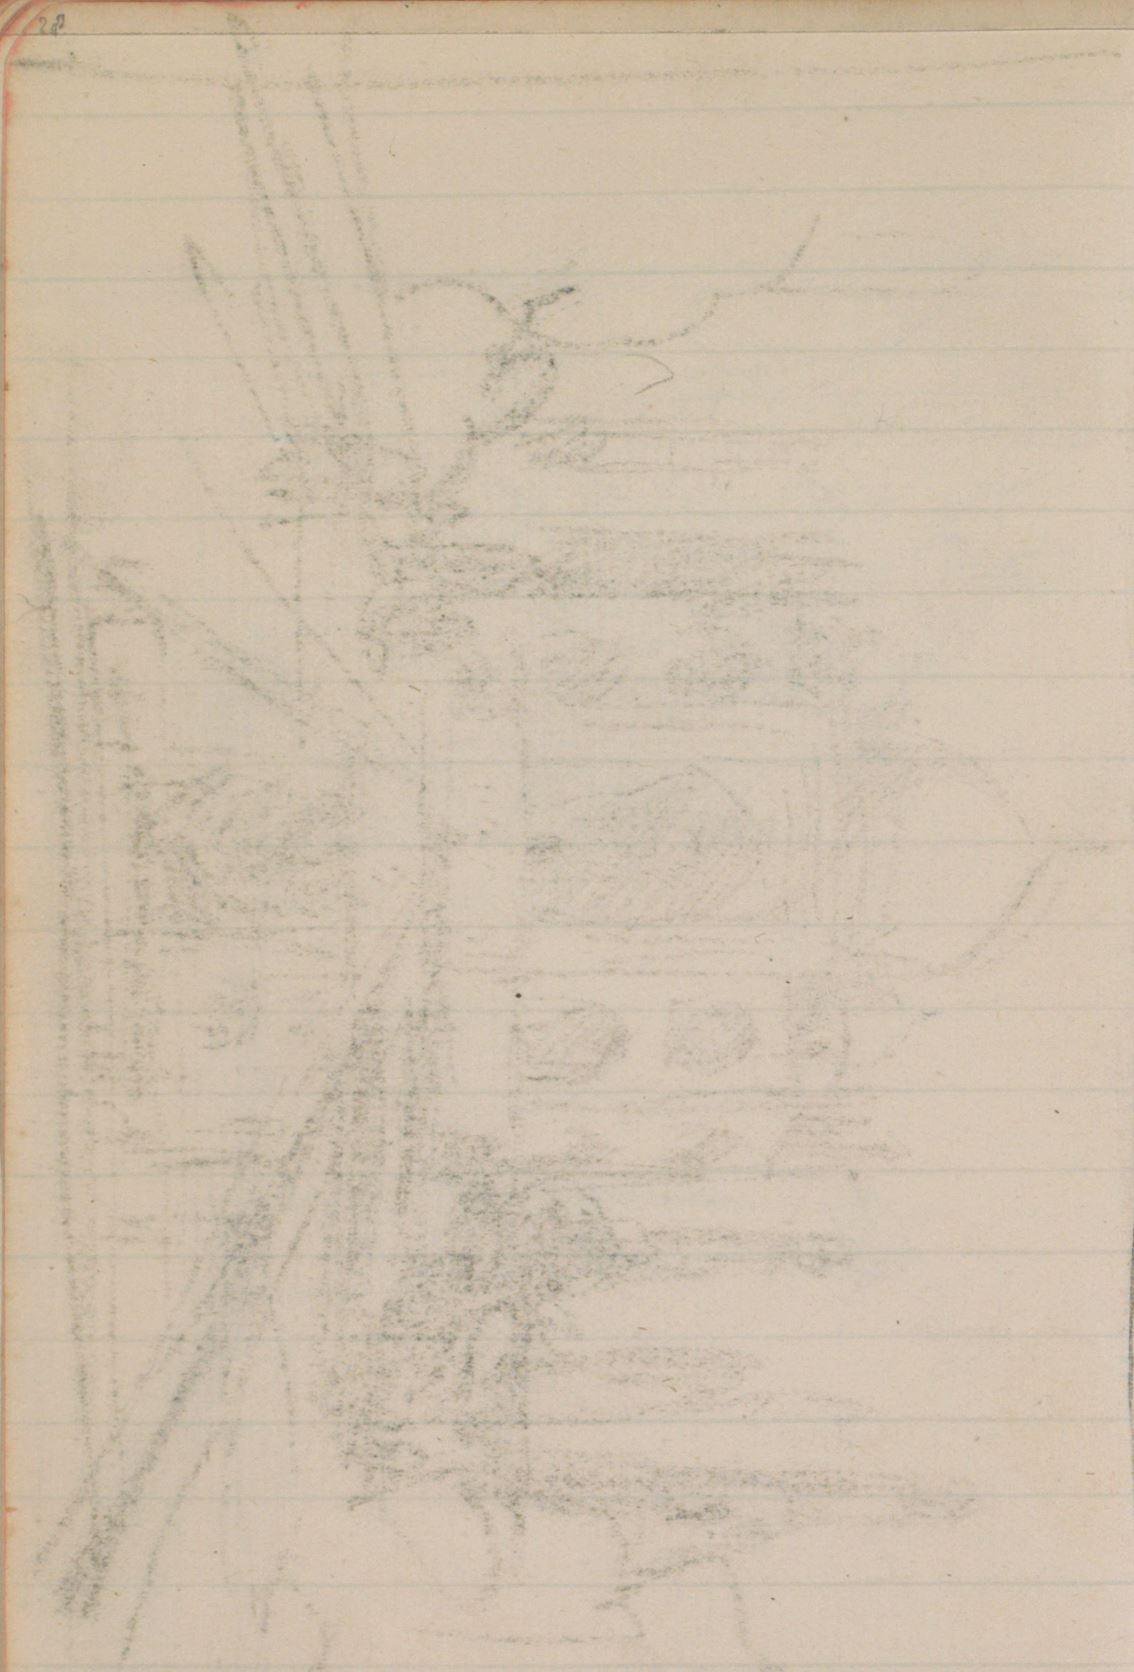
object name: sketchbook leaf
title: Abklatsch van een krijttekening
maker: marius bauer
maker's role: draughtsman, print maker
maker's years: 1867-1932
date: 1897-1898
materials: lined paper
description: De tekening is niet langer in het schetsboek aanwezig en stelt een aanzicht van de Taj Mahal voor. Pagina 28 uit een schetsboek met 36 bladen.